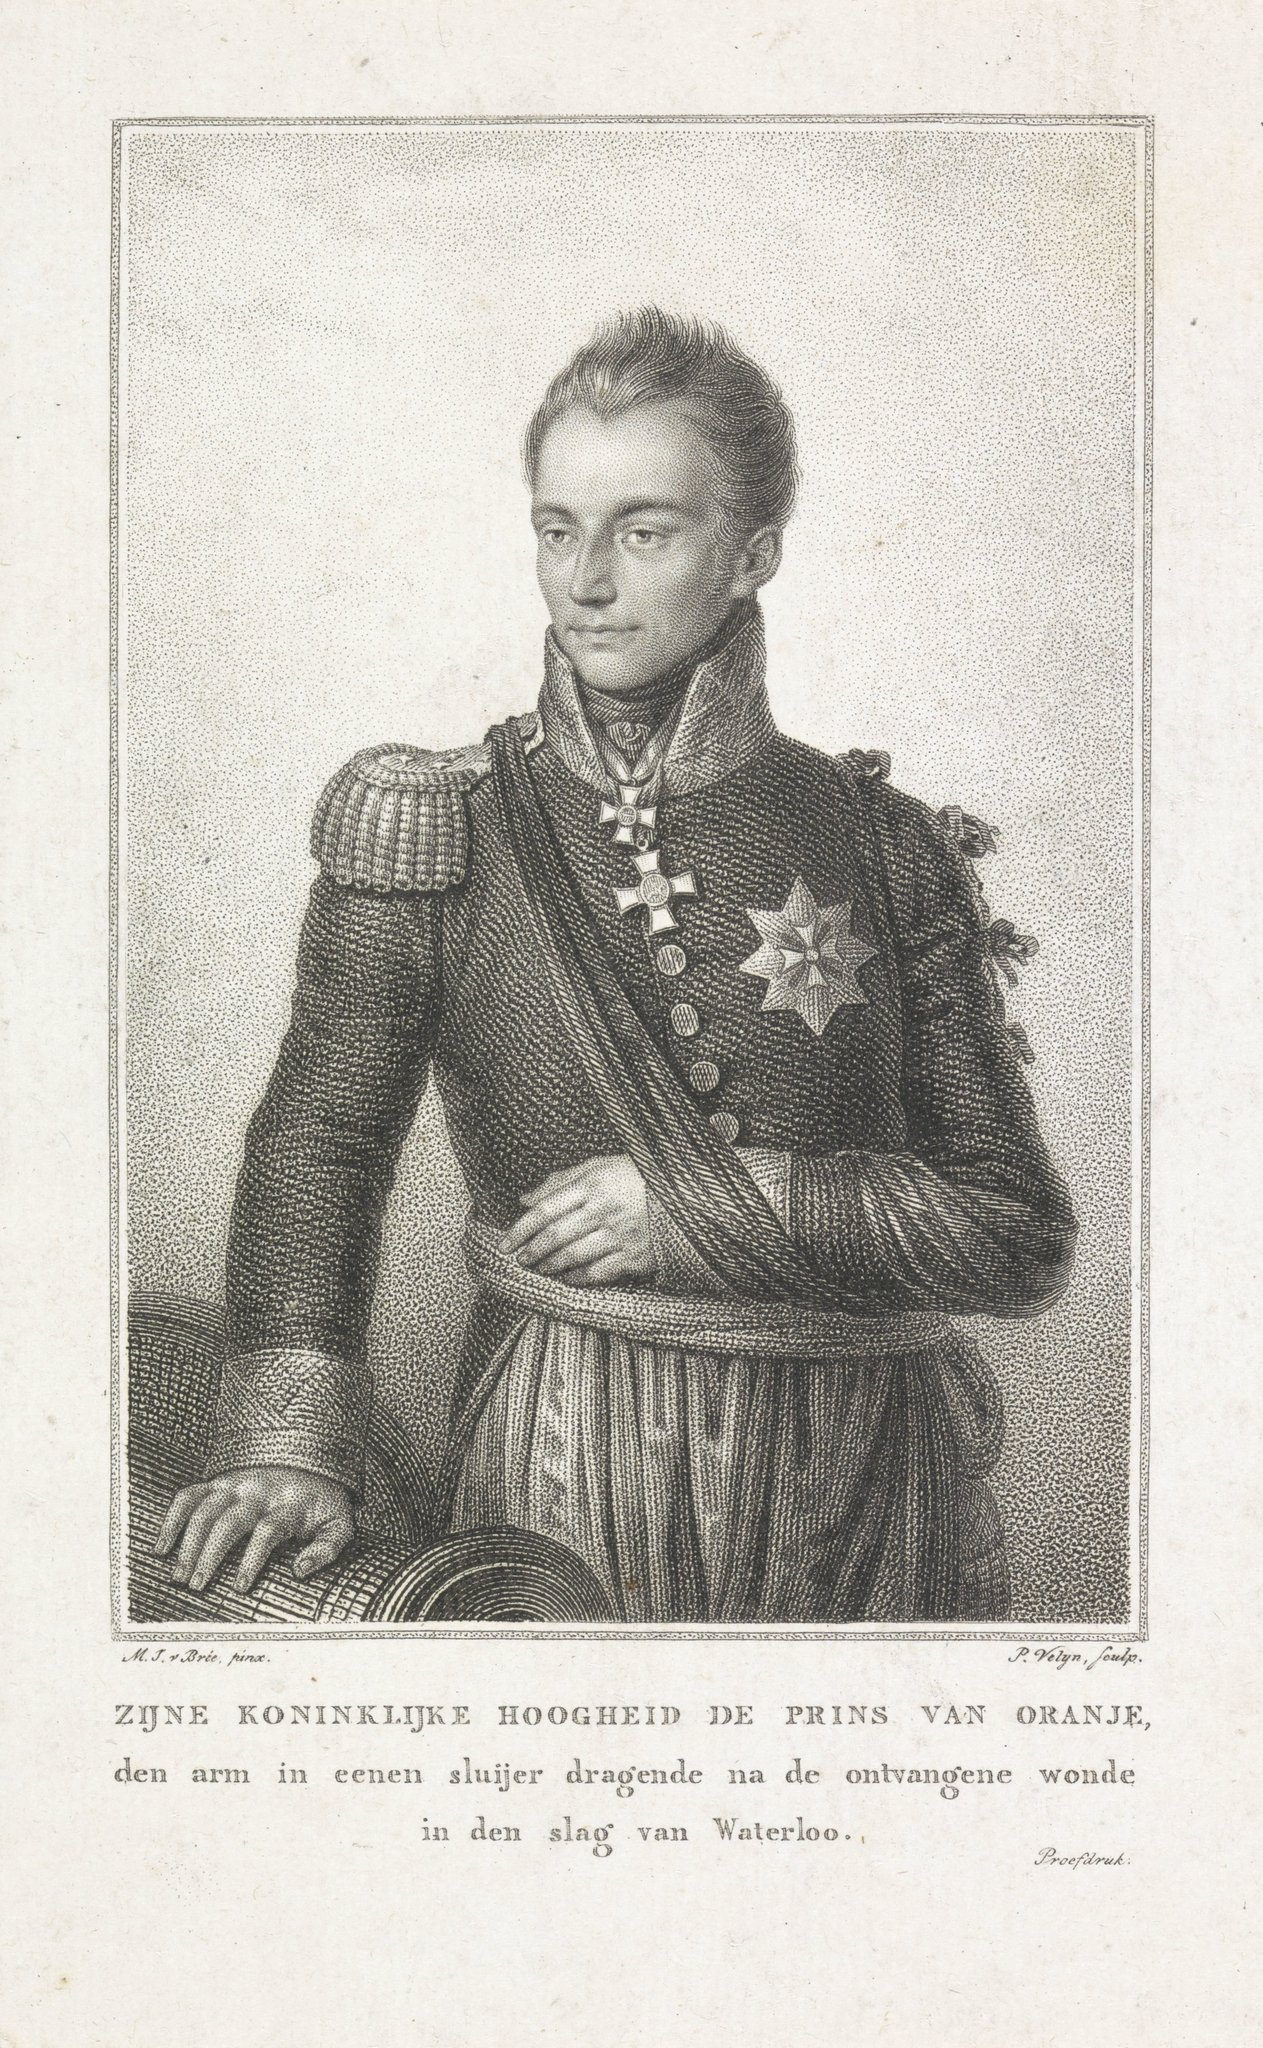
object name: print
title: Zijne Koninklijke Hoogheid de Prins van Oranje, den arm in eenen sluijer dragende na de ontvangene wonde in den slag van Waterloo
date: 1815-1816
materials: paper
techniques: engraving, etching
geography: netherlands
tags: william ii of the netherlands, medical aid and nursing of the sick and wounded, waterloo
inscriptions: collector's mark: Lugt 2228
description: De gewonde prins van Oranje, met de arm in een verband, staande naast een kanon. Onderdeel van een groep illustraties van gebeurtenissen rond en tijdens de veldslagen bij Quatre-Bras en Waterloo, 16-18 juni 1815.